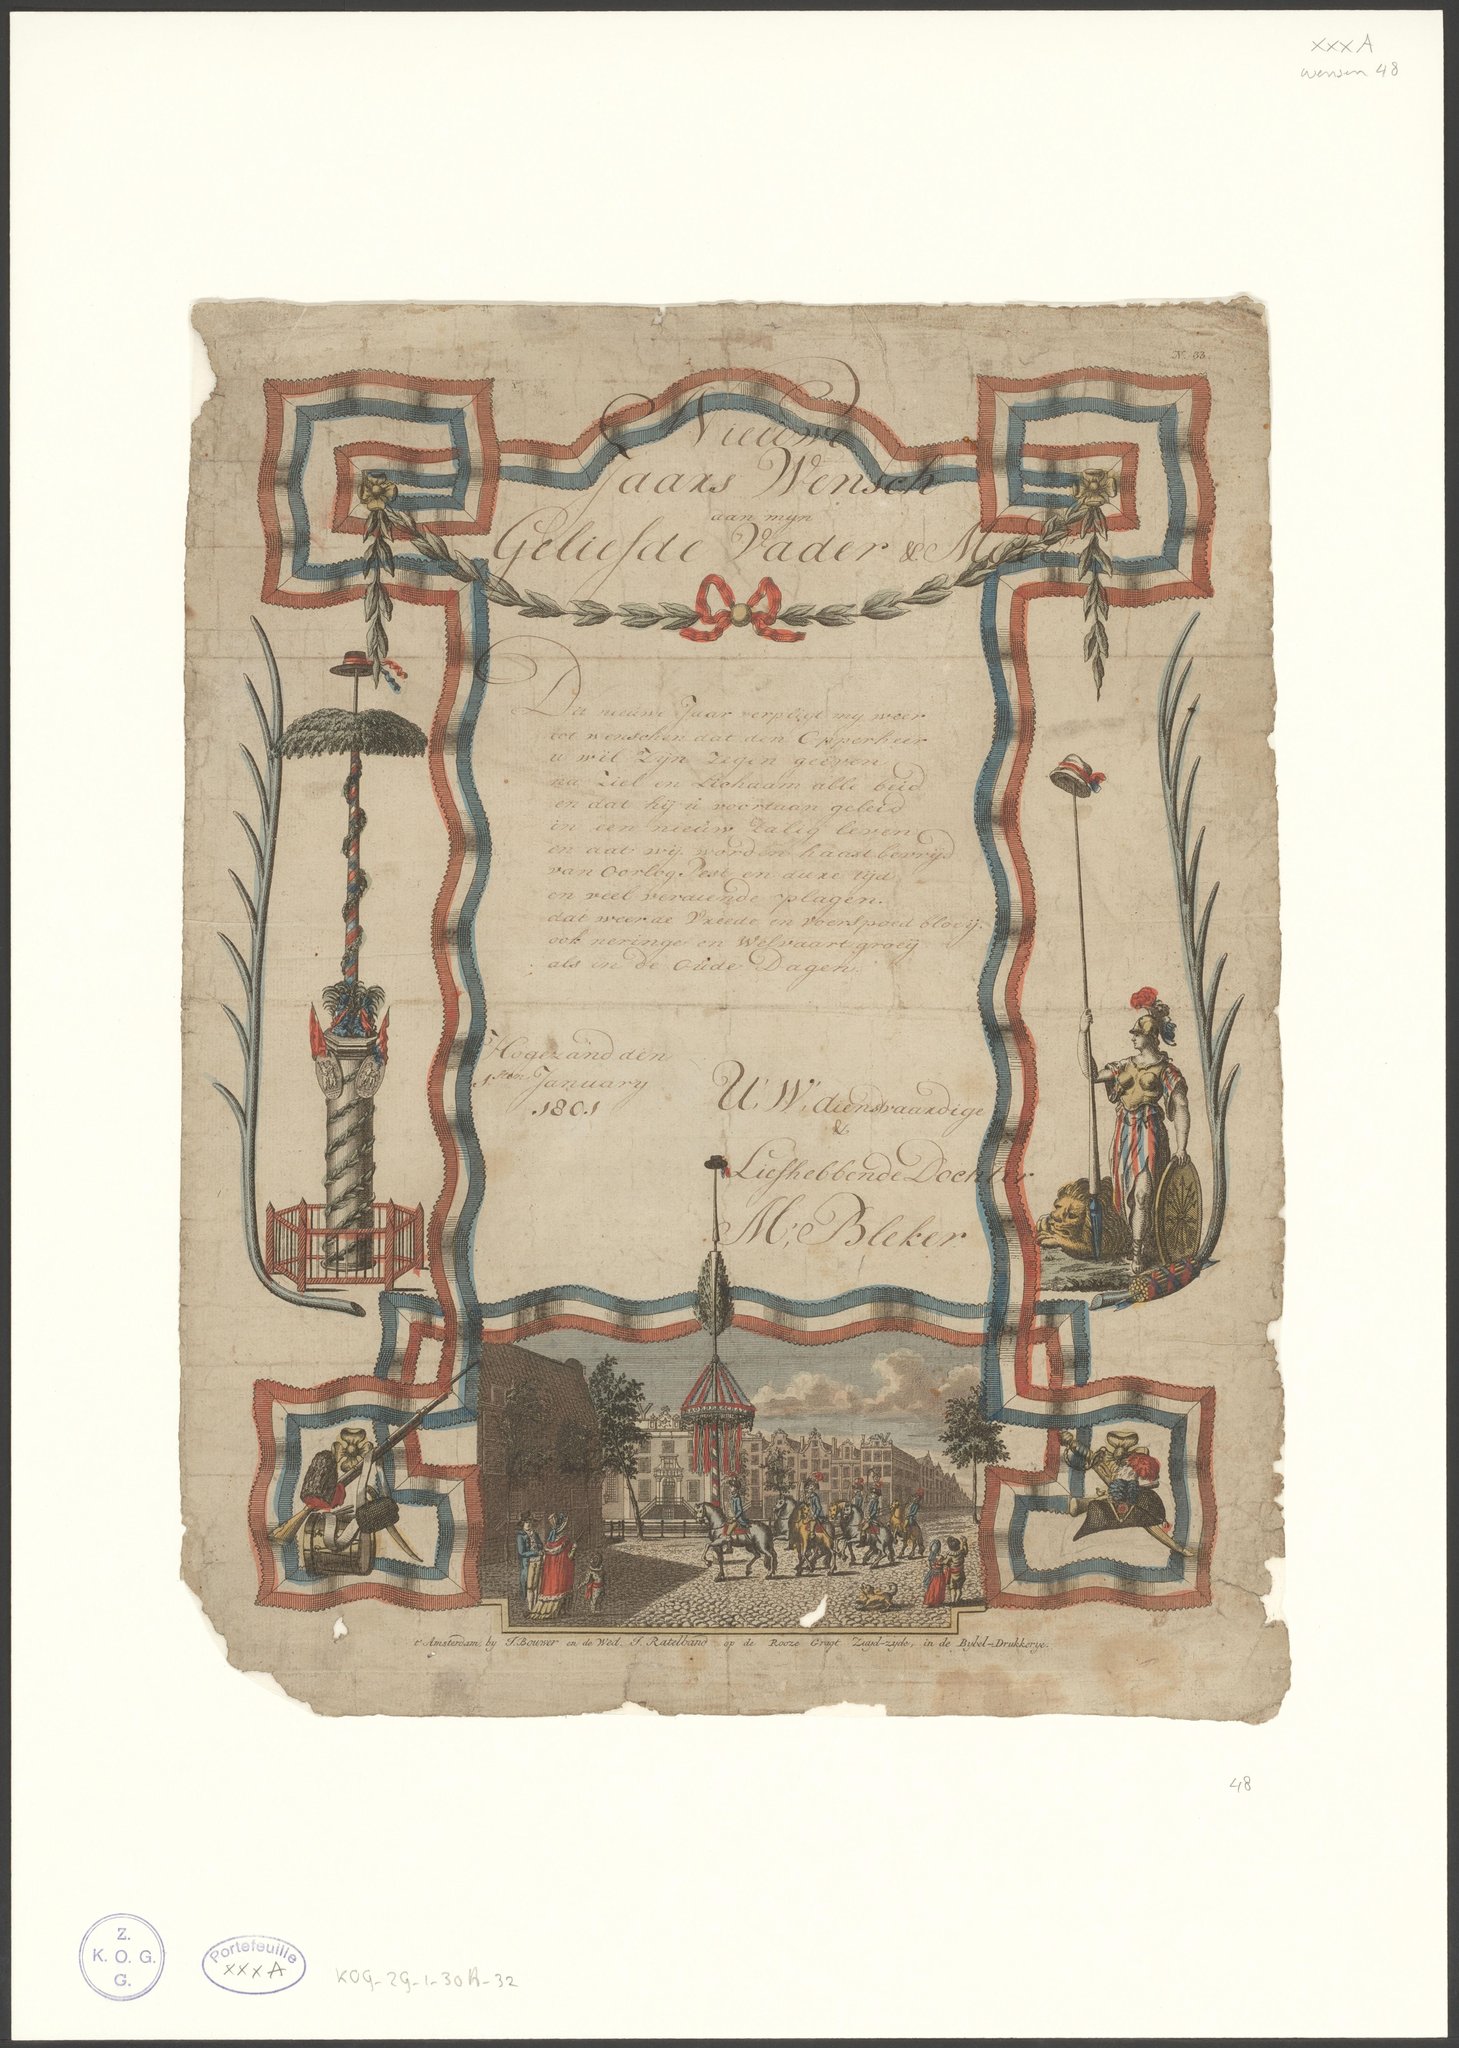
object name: print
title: Nieuwjaarswens van M. Bleker, 1801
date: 1801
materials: ink, paper, watercolor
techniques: etching, hand coloring, handwriting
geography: amsterdam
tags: january 1 (~ festivities), freedom, liberty; 'libertà' (ripa), flag, colours (as symbol of the state, etc.), dancing around the tree of liberty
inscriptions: collector's mark: Lugt 1641, collector's mark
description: Nieuwjaarswens van M. Bleker, 1 januari 1801. Gericht aan haar vader en moeder. Voorgedrukt blad met een kader gevormd door een lint van de Nederlandse vlag en elementen van de Bataafse Republiek. Genummerd rechtsboven: N. 33. Onderwerpsrubrieken binnen de Atlas Zeden en Gewoonten: Nieuwjaars- en kermiswenschen.